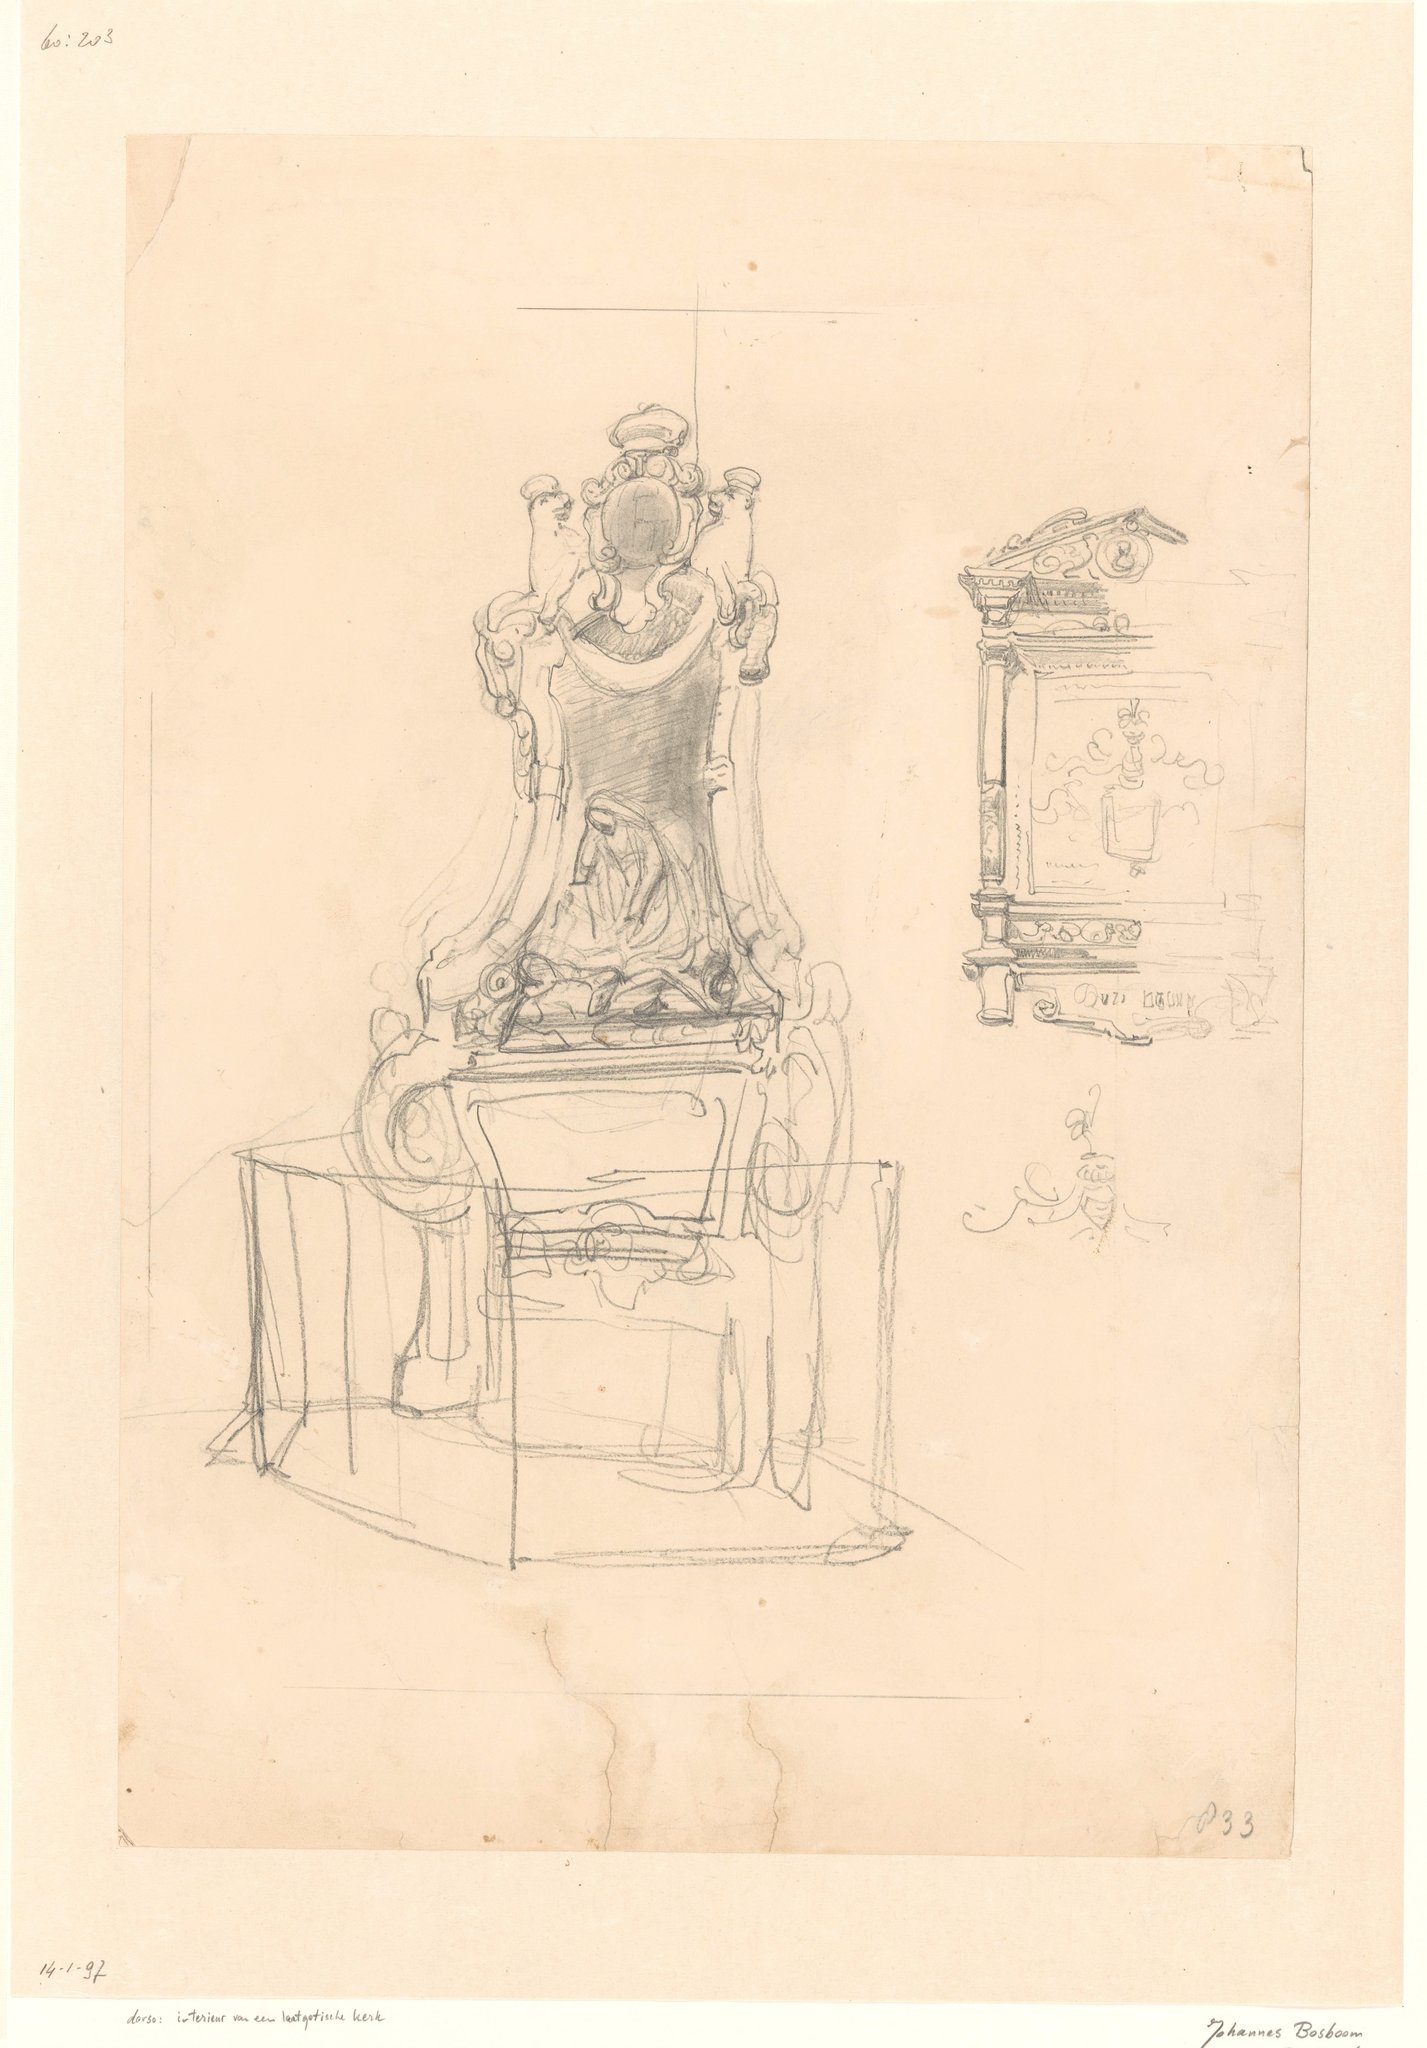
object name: drawing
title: Schetsblad met studies van een grafmonument en een epitaaf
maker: johannes bosboom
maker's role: draughtsman, painter, print maker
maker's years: 1817-1891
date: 1827-1891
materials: paper, pencil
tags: grave-building, monumental tomb, epitaph